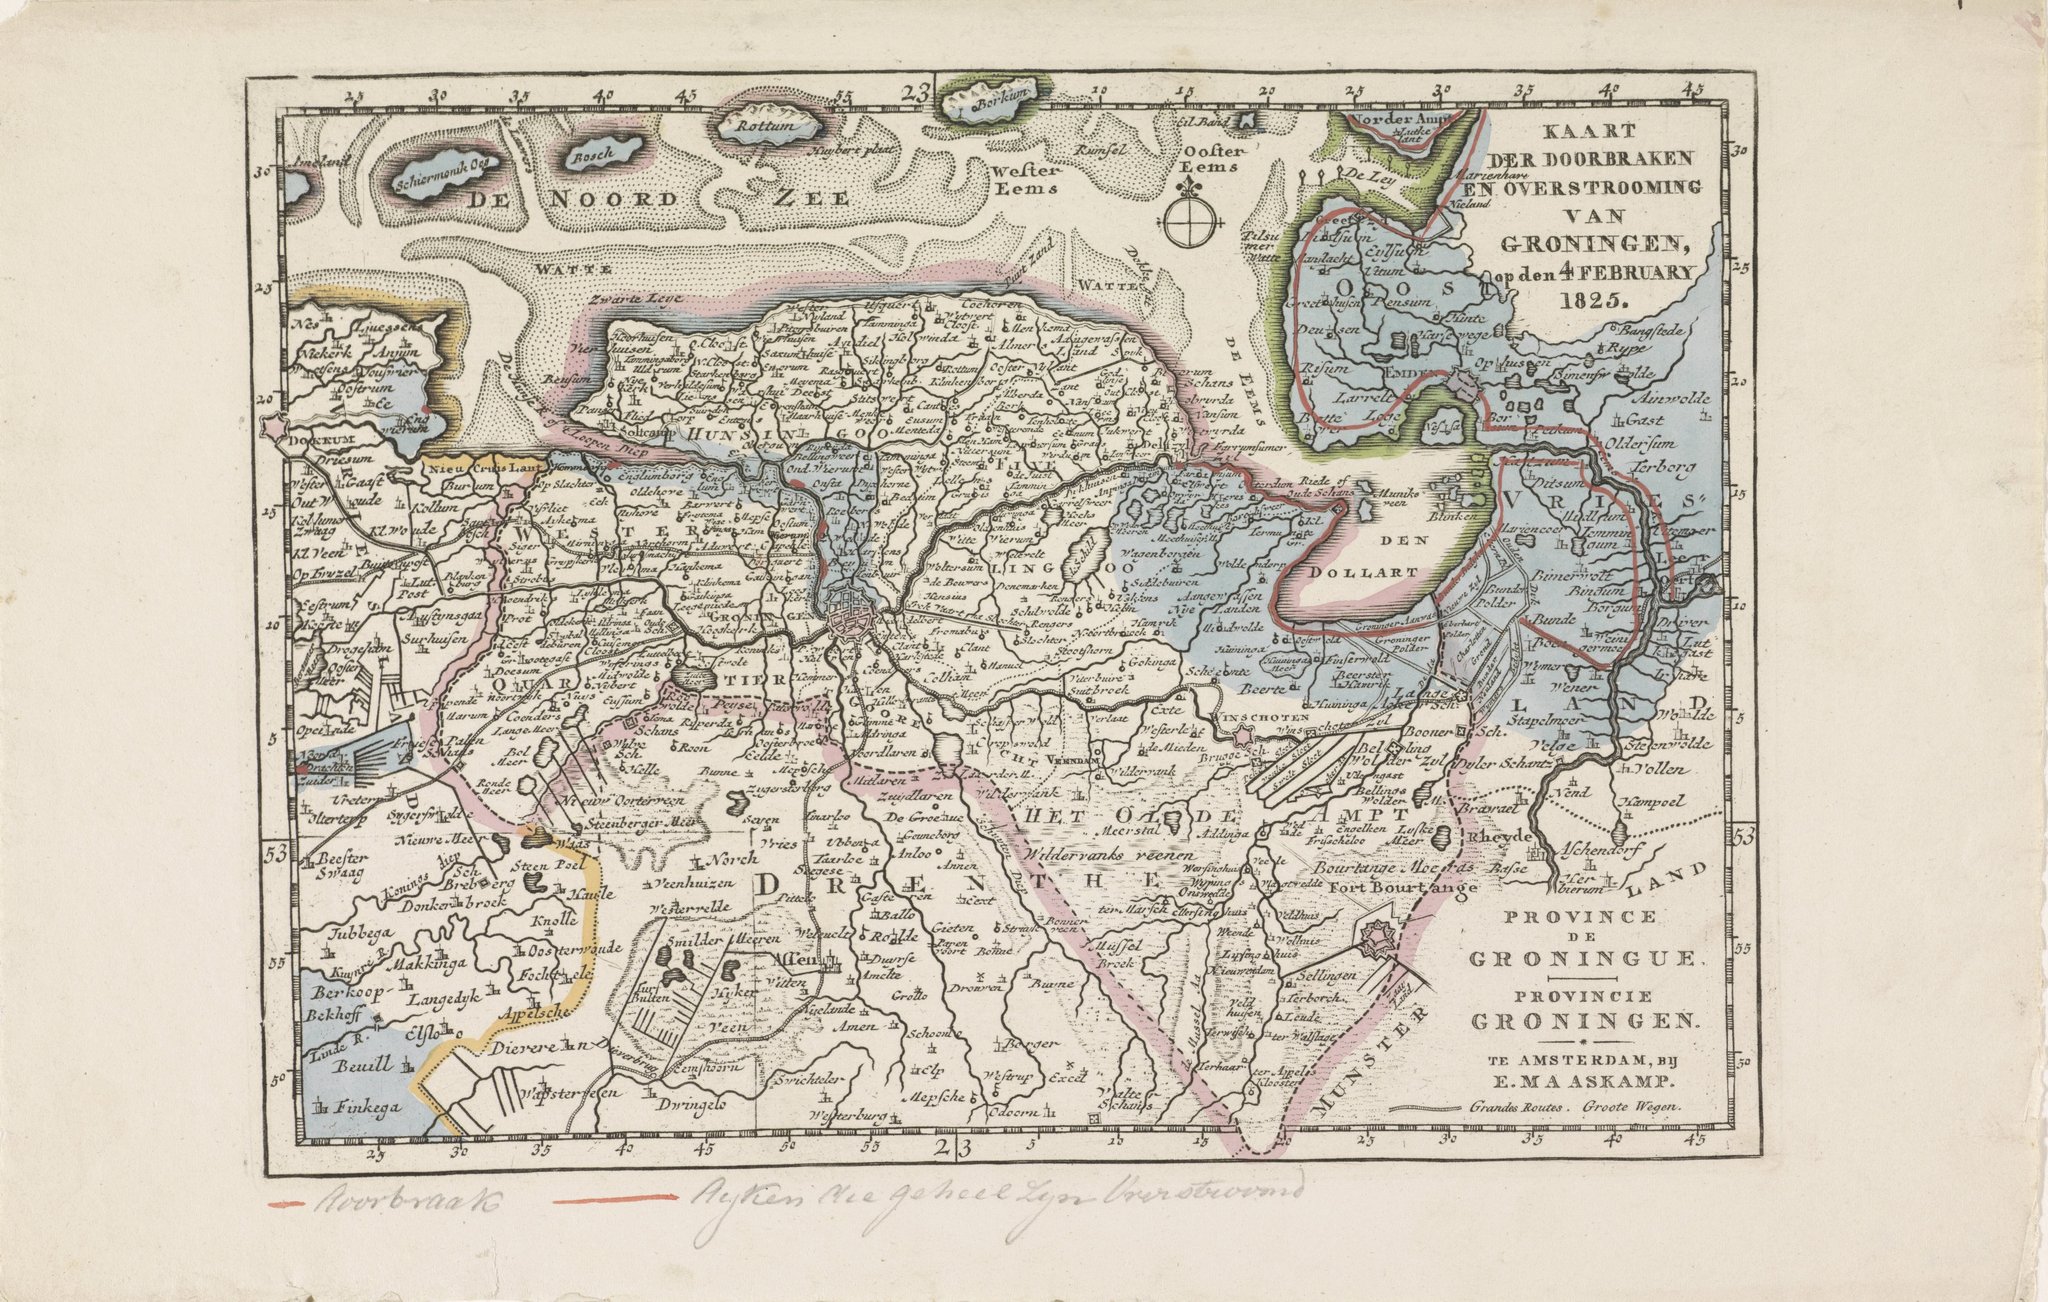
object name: print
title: Vijf kaarten van de in 1825 door watersnood getroffen gebieden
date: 1825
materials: paper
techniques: engraving, hand coloring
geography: netherlands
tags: maps of separate countries or regions, flood, groningen (province)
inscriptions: collector's mark: Lugt 2228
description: Kaart van de provincie Groningen en het Duitse Oost-Friesland, waarop in blauw zijn aangegeven de gebieden getroffen door de overstromingen in februari 1825 en met rood de plaatsen waar de dijken zijn doorgebroken. Onderaan het blad een regel handschrift. Onderdeel van een serie van vijf kaarten van de getroffen gebieden.